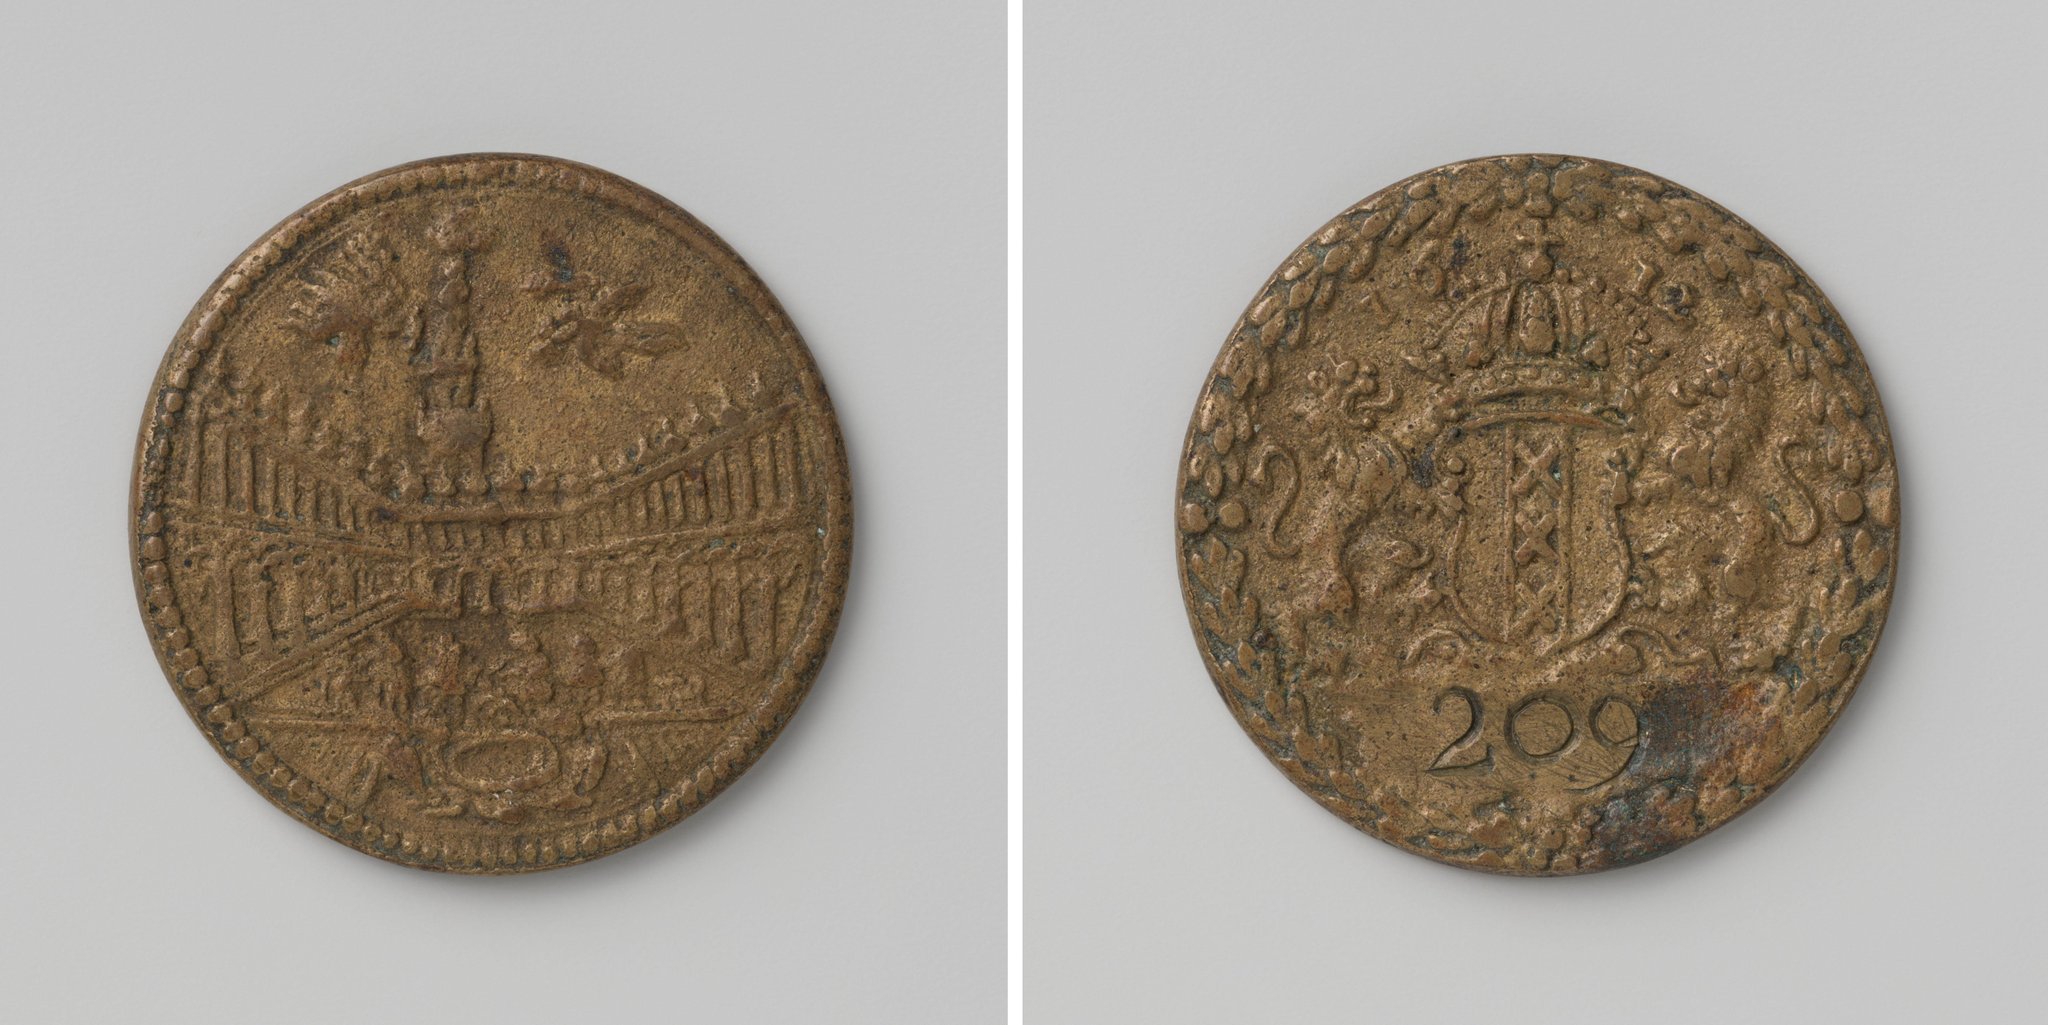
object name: medal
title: Makelaarsgilde van Amsterdam, gildepenning met no. 209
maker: hans rogiers van harelbeke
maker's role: metalworkers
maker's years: -1638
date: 1612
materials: brass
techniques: casting, engraving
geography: amsterdam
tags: amsterdam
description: Messing penning. Voorzijde: gezicht op beursgebouw, waarboven twee Mercuriussen vliegen met staf en buidel in handen. Keerzijde: gekroond wapenschild, geflankeerd door twee leeuwen onder jaartal binnen palmkrans; afsnede: cijfer 209